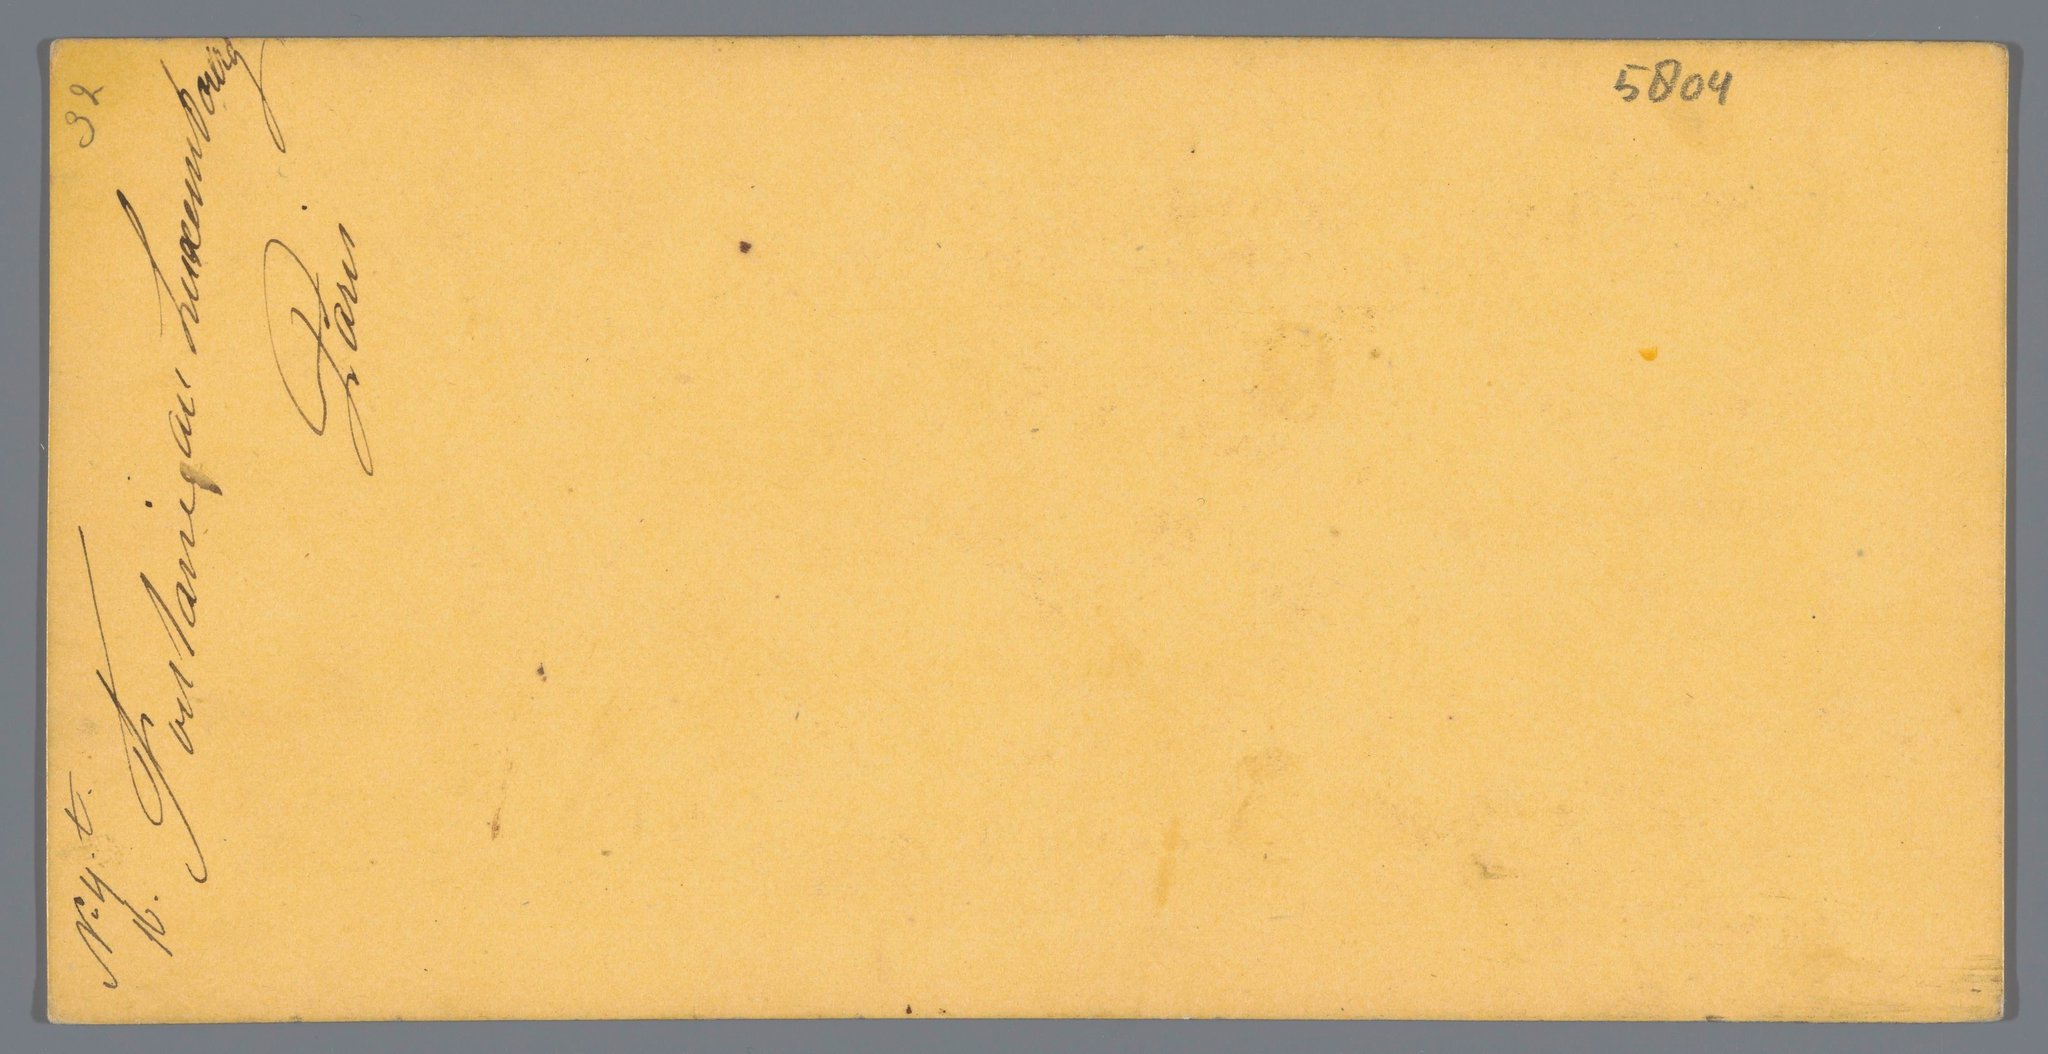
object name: stereograph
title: Gezicht op de Fontaine Médicis in de Jardin du Luxembourg in Parijs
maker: Anonymous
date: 1850-1880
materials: cardboard, photographic support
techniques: albumen print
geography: jardin du luxembourg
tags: garden fountain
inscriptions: number: ‘32’, number: ‘No 4. t. 16’, inscription: ‘Fontaine au Luxenbourg Paris’